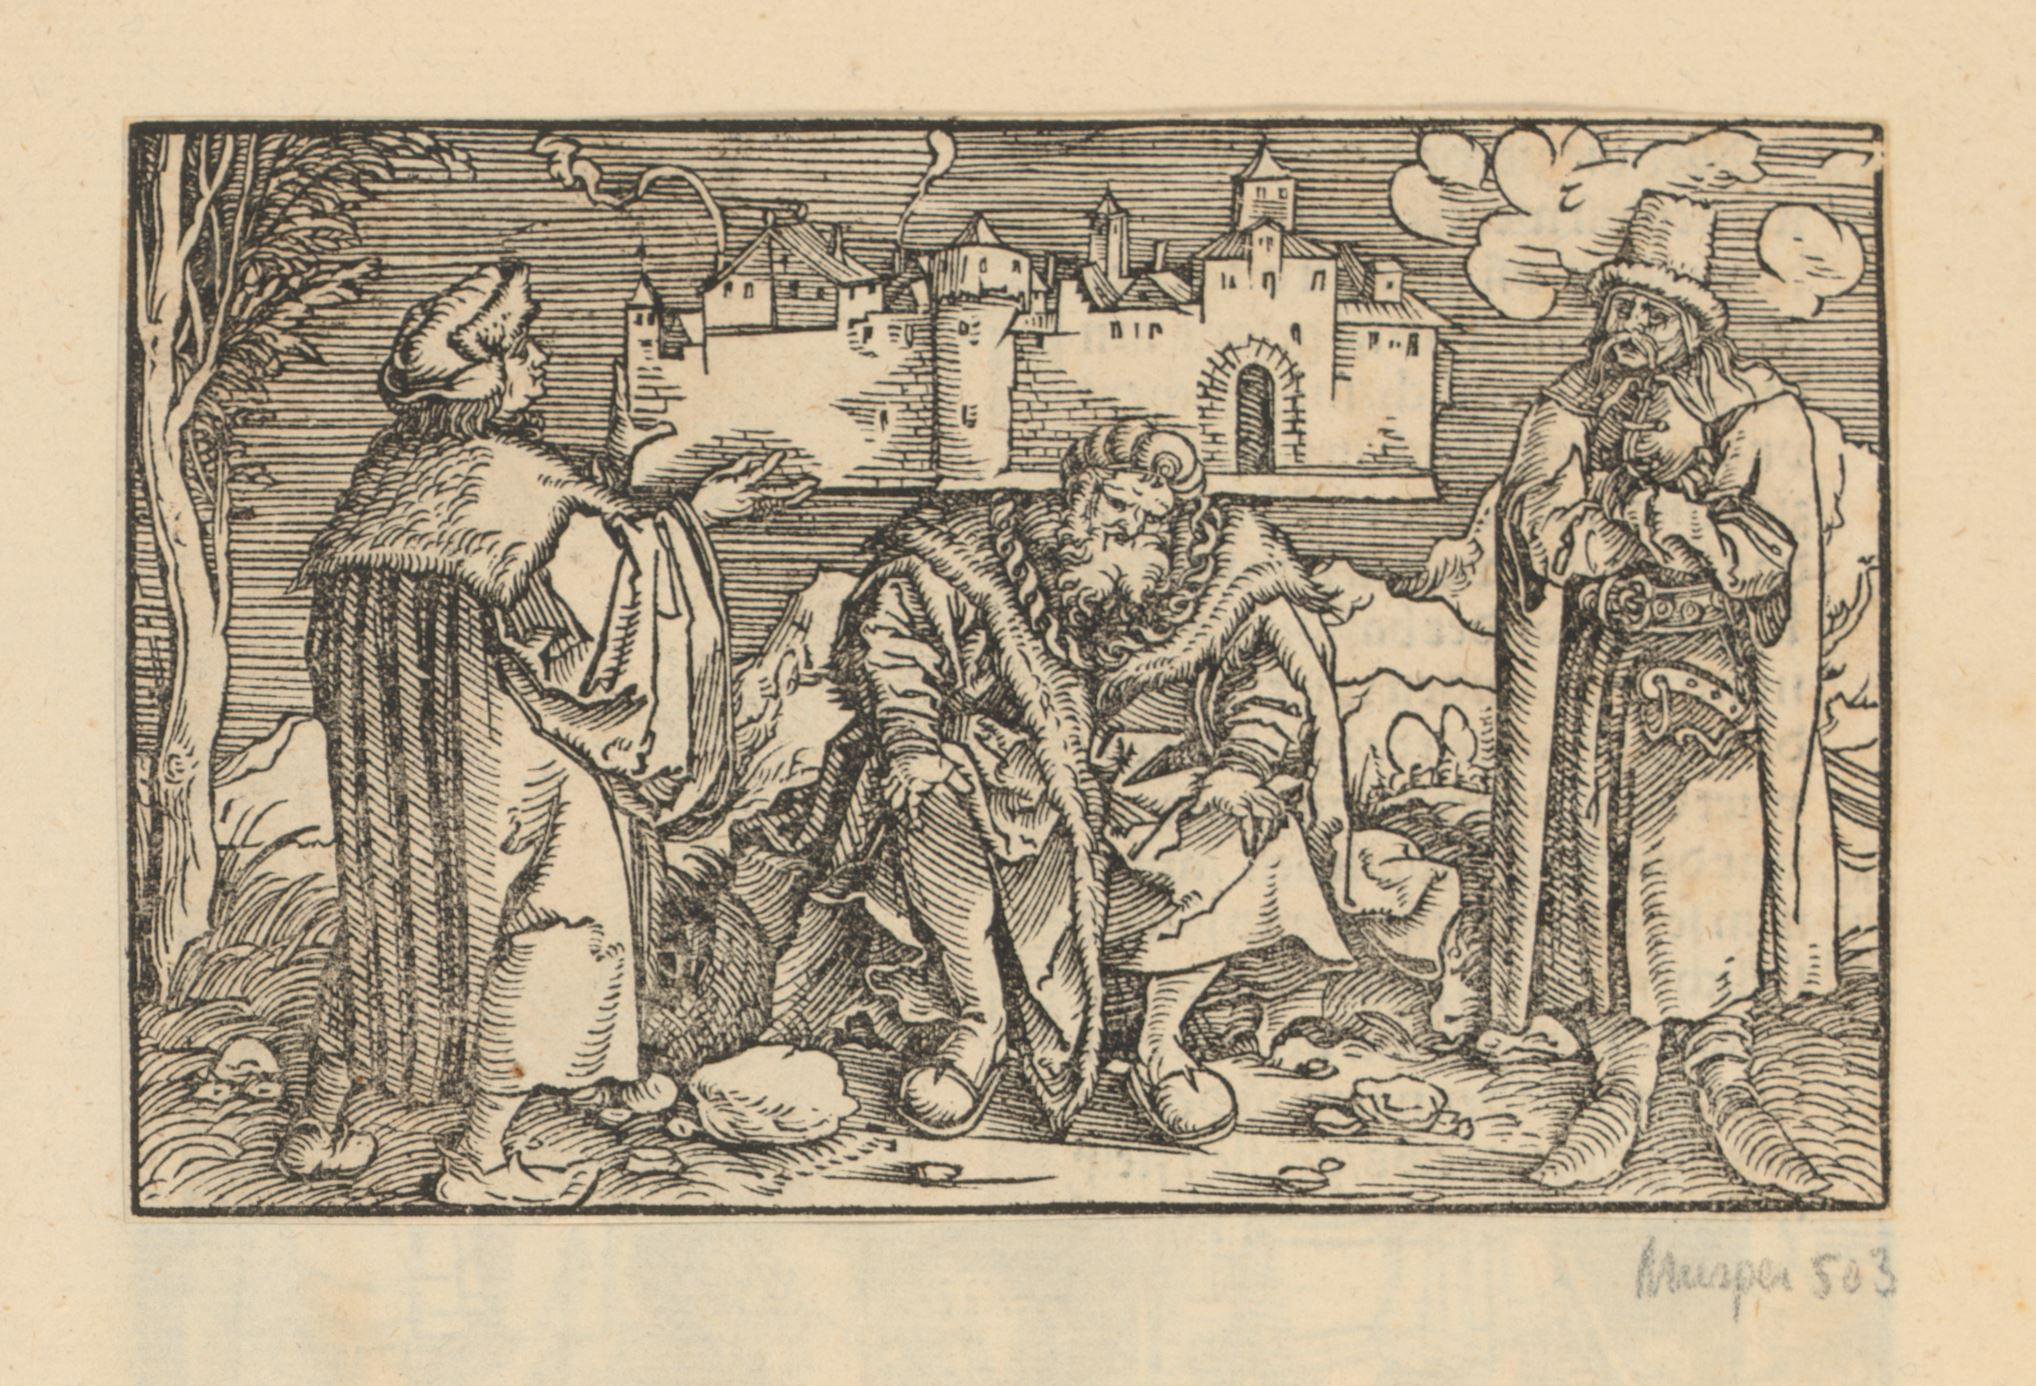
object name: album leaf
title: Burgemeester gaat gebukt onder de last van zijn stad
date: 1514-1531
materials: paper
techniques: letterpress printing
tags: mayor, burgomaster, sense of duty, devotion to duty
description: Deze prent is gebruikt in: Cicero, Marcus Tulius. Officia M.T.C. Ein Buch so Marcus Tullius Cicero der Römer zu seynem (...). [Vertaald uit het Latijn door] Johann von Schwarzenberg. Augsburg: Heinrich Steiner, 1531.